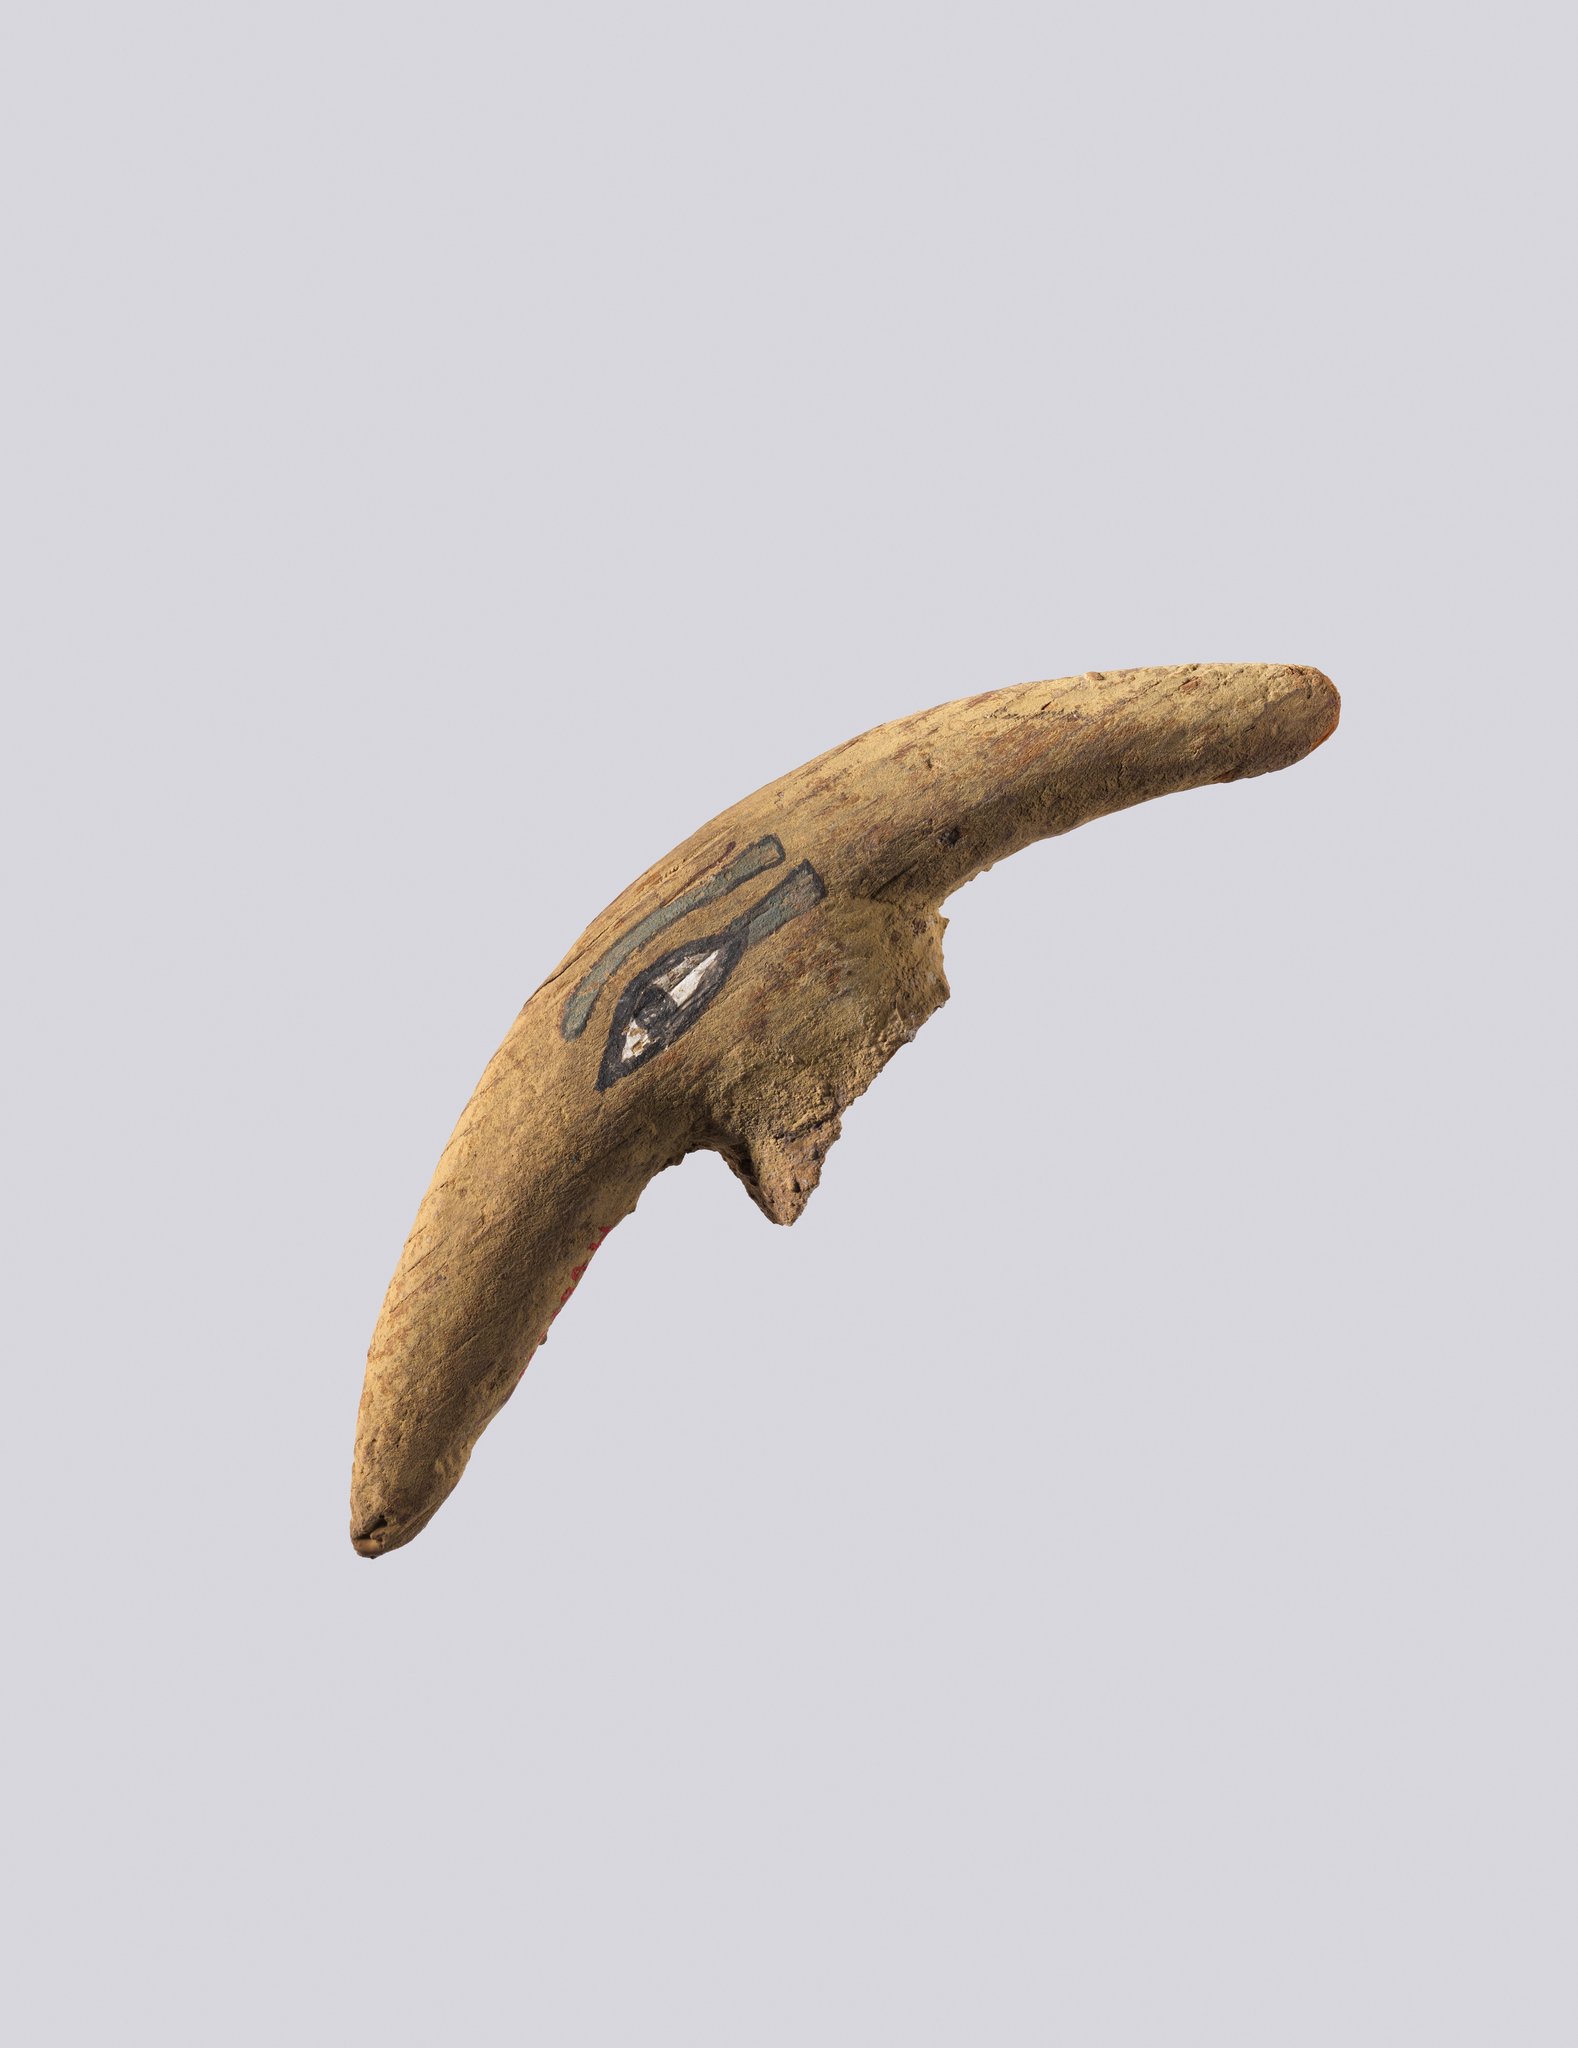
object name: wa scepter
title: Head of a was scepter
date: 1859-1813 BCE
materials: wood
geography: egypt